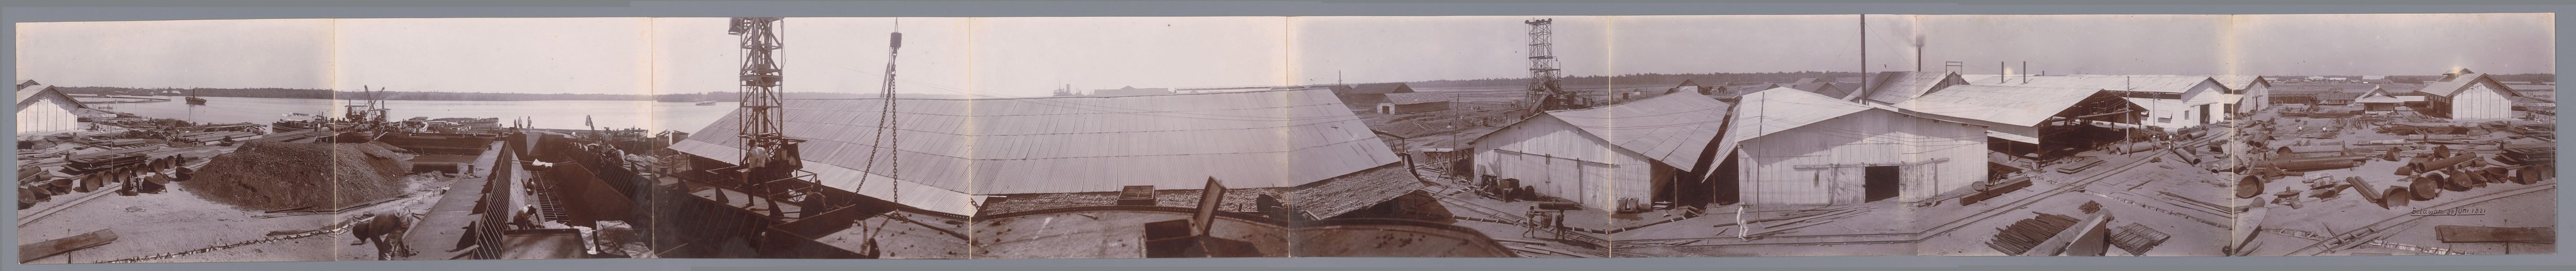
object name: photograph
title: Oceaanhaven Belawan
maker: Anonymous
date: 1921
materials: photographic support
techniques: gelatin silver print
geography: belawan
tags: harbour, building-site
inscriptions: inscription: ‘No. 39 / Oceaanhaven Belawan / Panorama werkterrein’, date: ‘Belawan. 30 Juni 1921’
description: Gezicht over het gehele werkterrein voor de aanleg van de haven. Panorama opgebouwd uit 8 aan elkaar geplakte foto's. Genummerd: 39. Onderdeel van de groep van losse foto's over de aanleg van de haven Belawan aan de kust voor Medan, Sumatra 1921-1922.